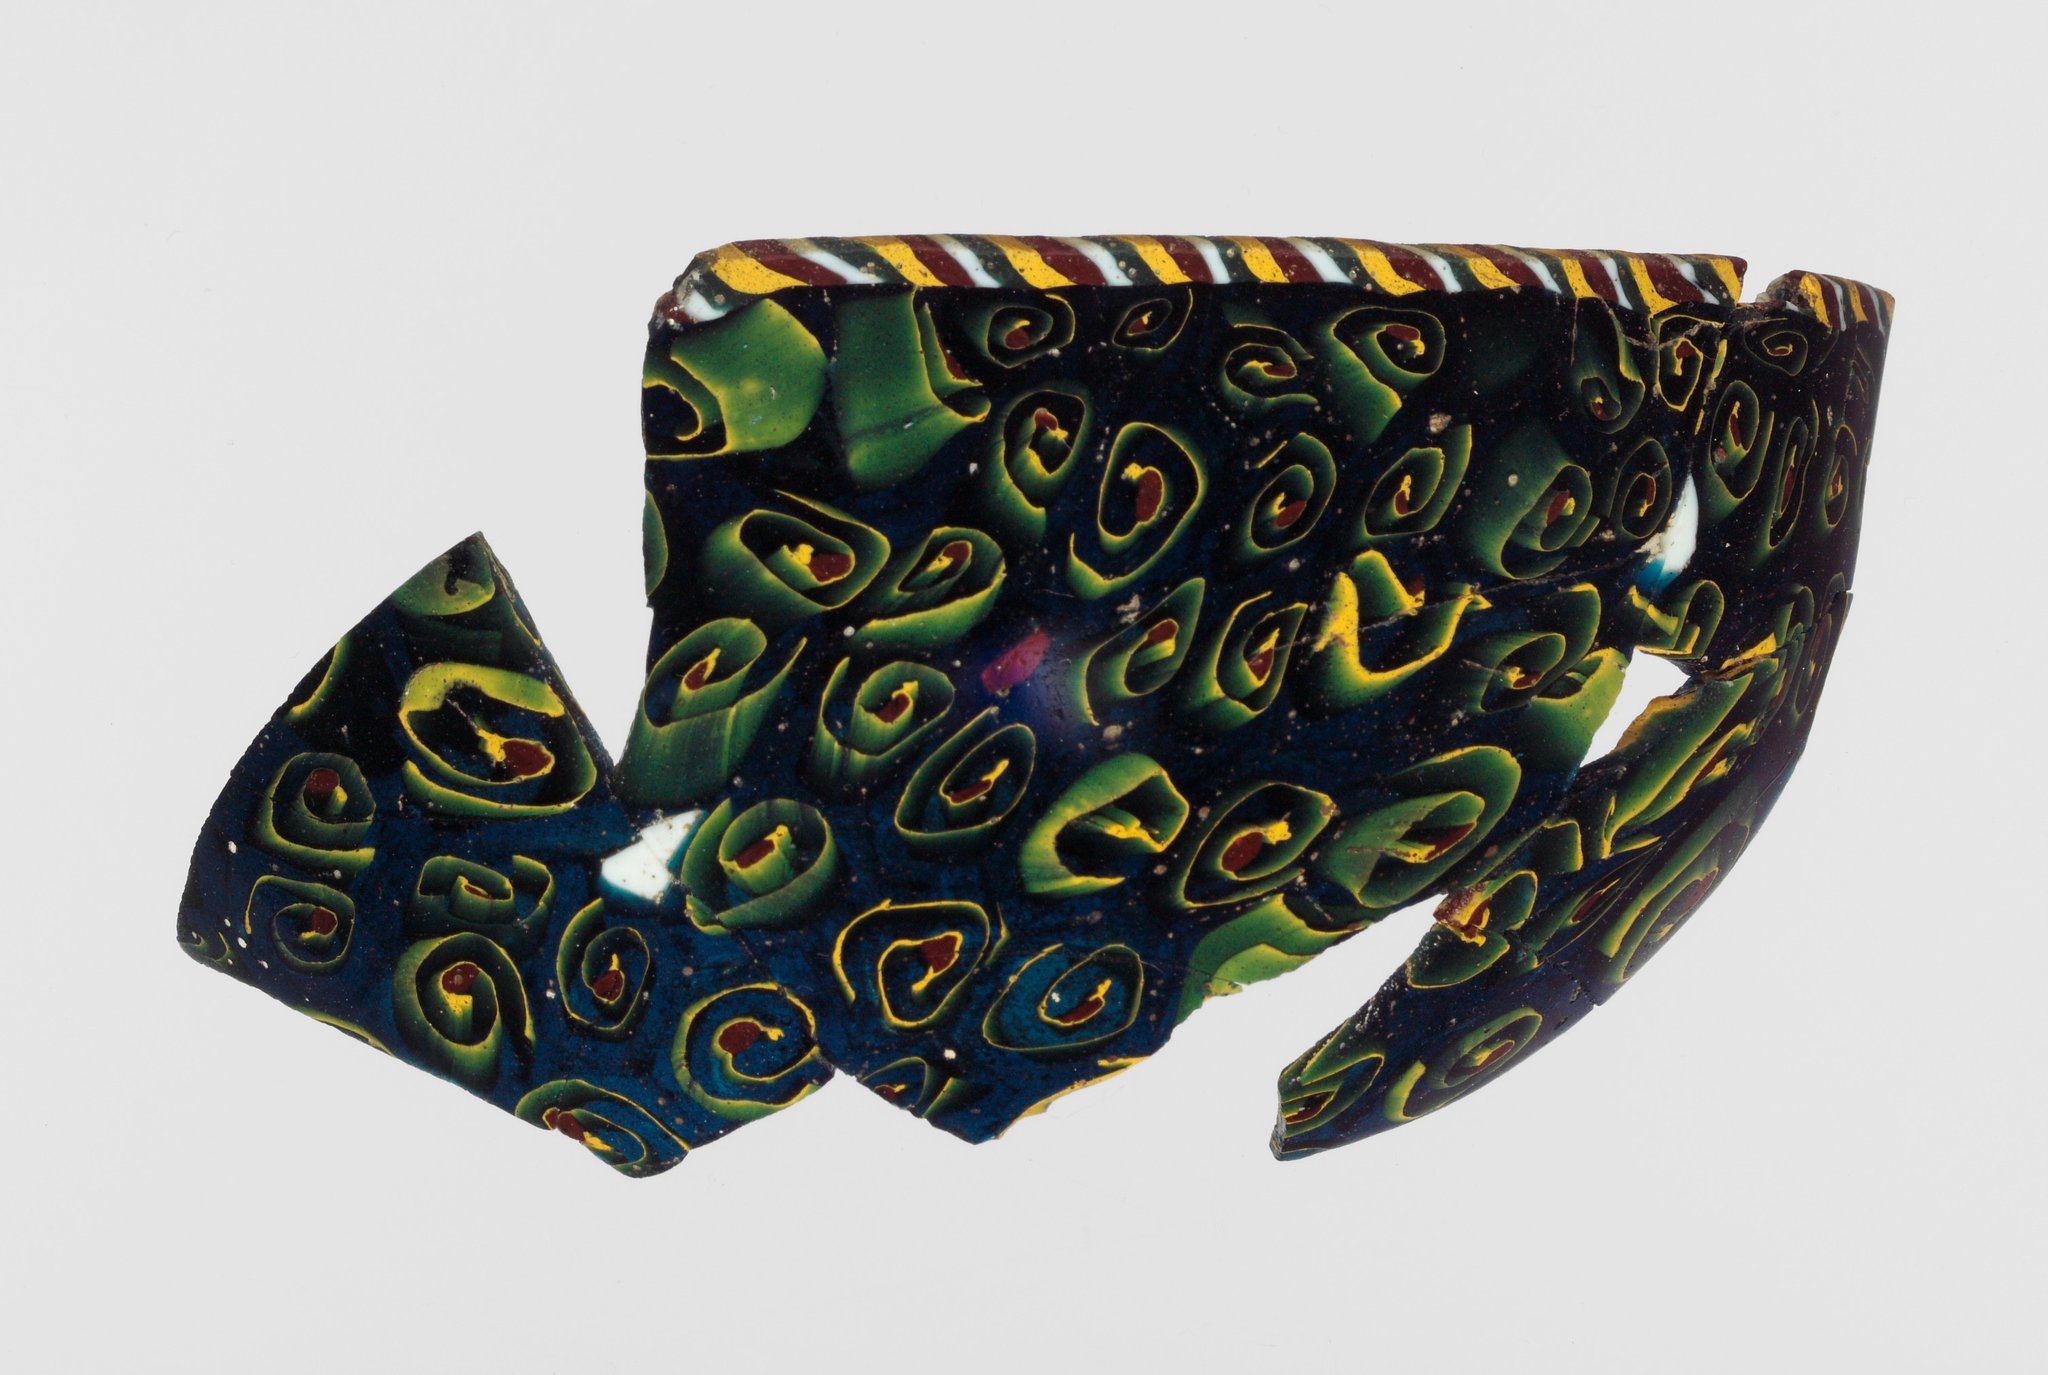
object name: fragment, mosaic bowl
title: Glass mosaic bowl fragments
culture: greek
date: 200-1 BCE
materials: glass